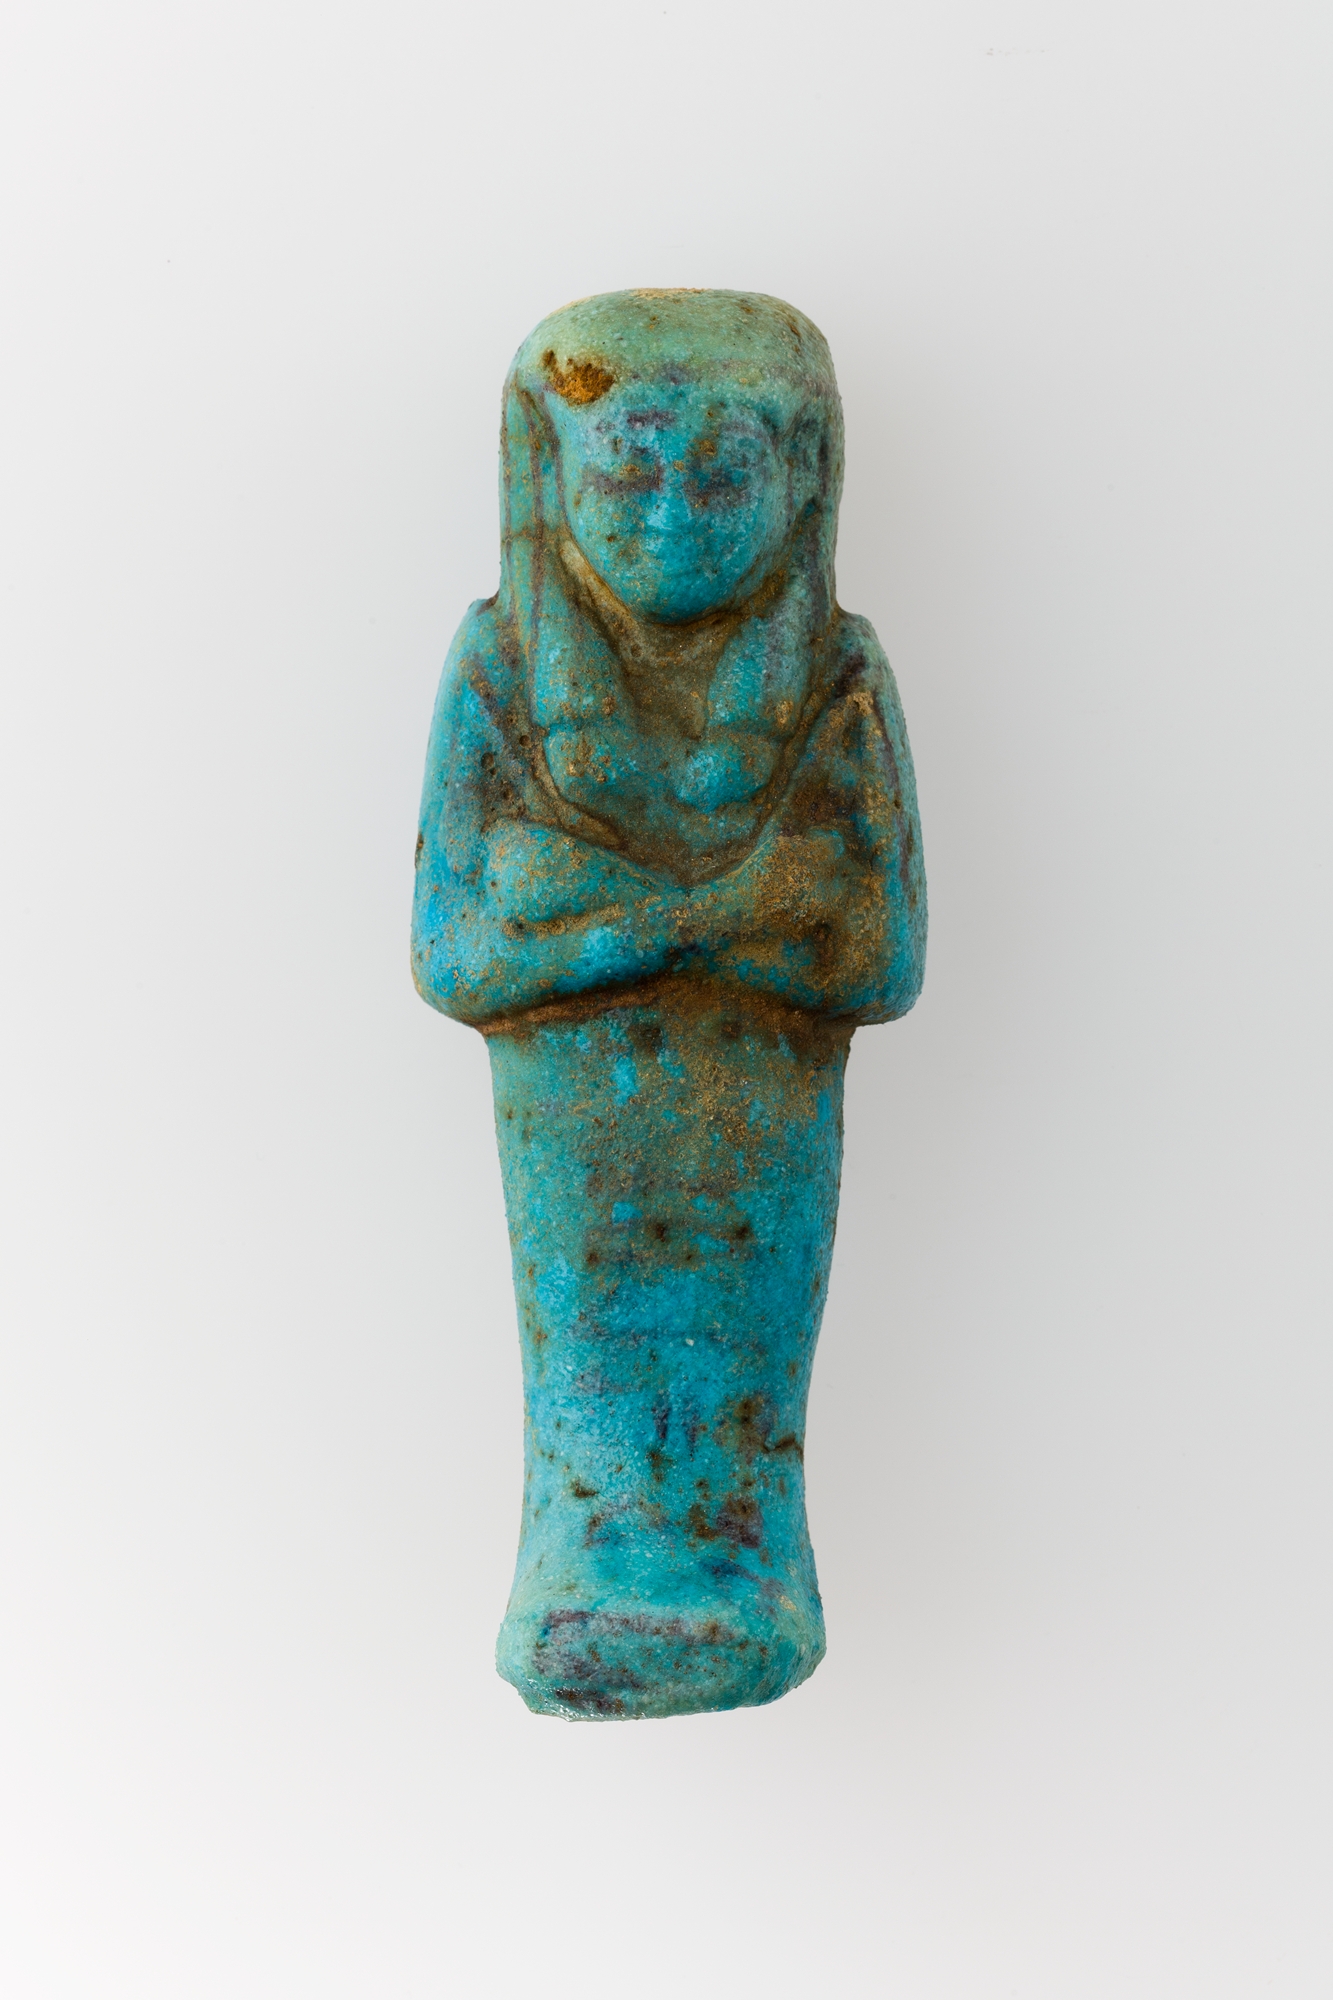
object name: shabti, henettawy c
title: Worker Shabti of Henettawy (C), Daughter of Isetemkheb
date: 990-970 BCE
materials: faience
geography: egypt